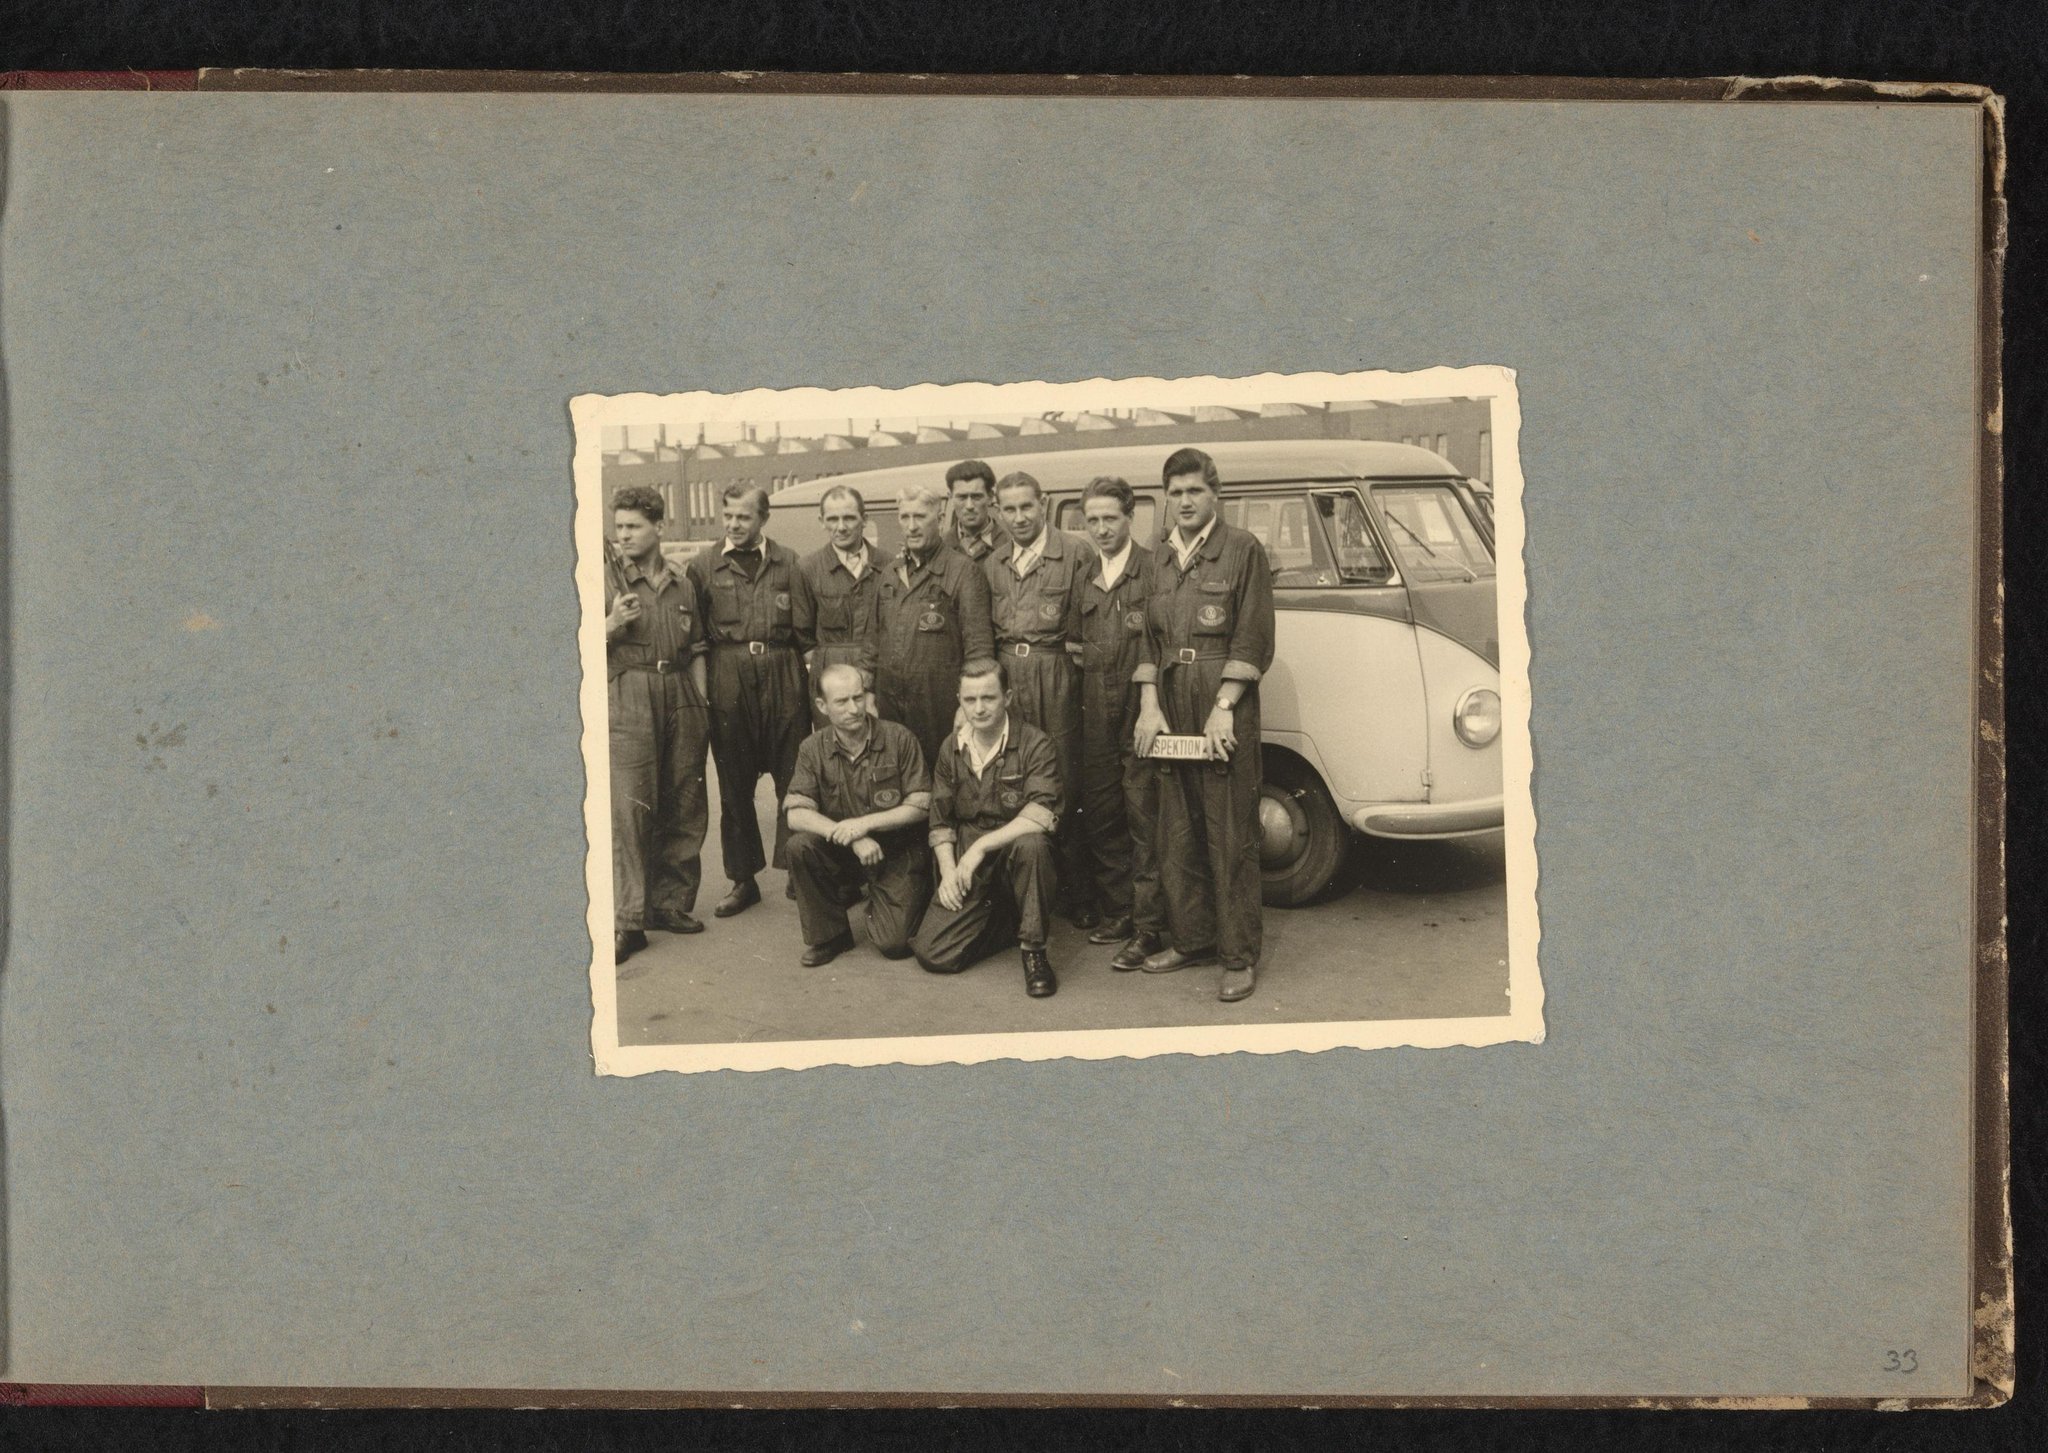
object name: photograph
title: Volkswagenfabriek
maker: Anonymous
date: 1945-1955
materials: paper, photographic support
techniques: gelatin silver print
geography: germany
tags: factory-interior, machine shop, automobile, germany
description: Albumblad met een foto van een groep werknemers, waaronder Glitsch, voor een Volkswagenbusje, in een Volkswagenfabriek na de oorlog Onderdeel van een fotoalbum over de diensttijd van Dieter Glitsch uit Hardegsen tijdens de Tweede Wereldoorlog en de jaren daarna.